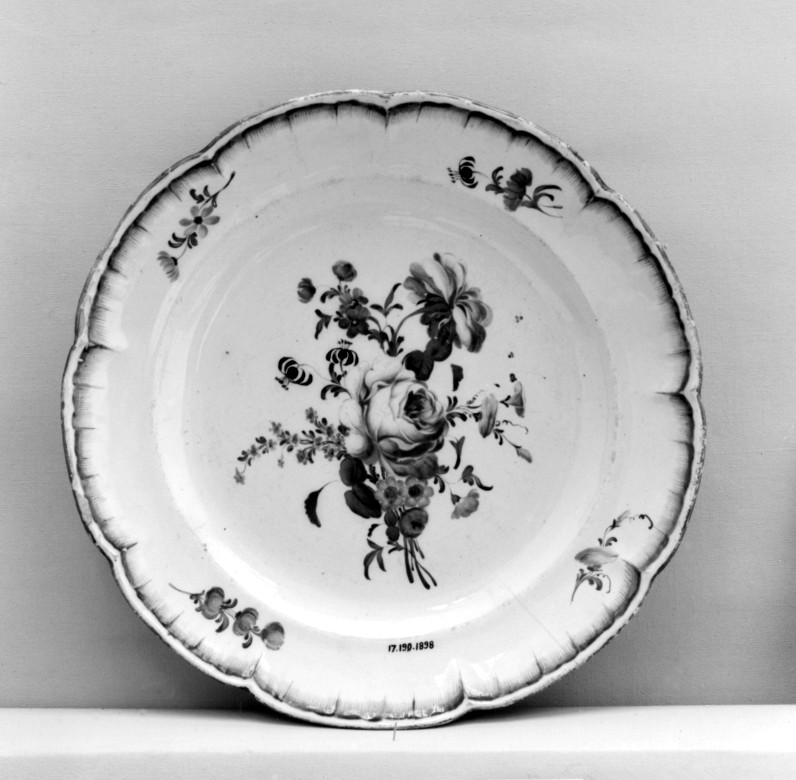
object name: plate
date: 1735-1795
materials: faience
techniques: glazing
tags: roses